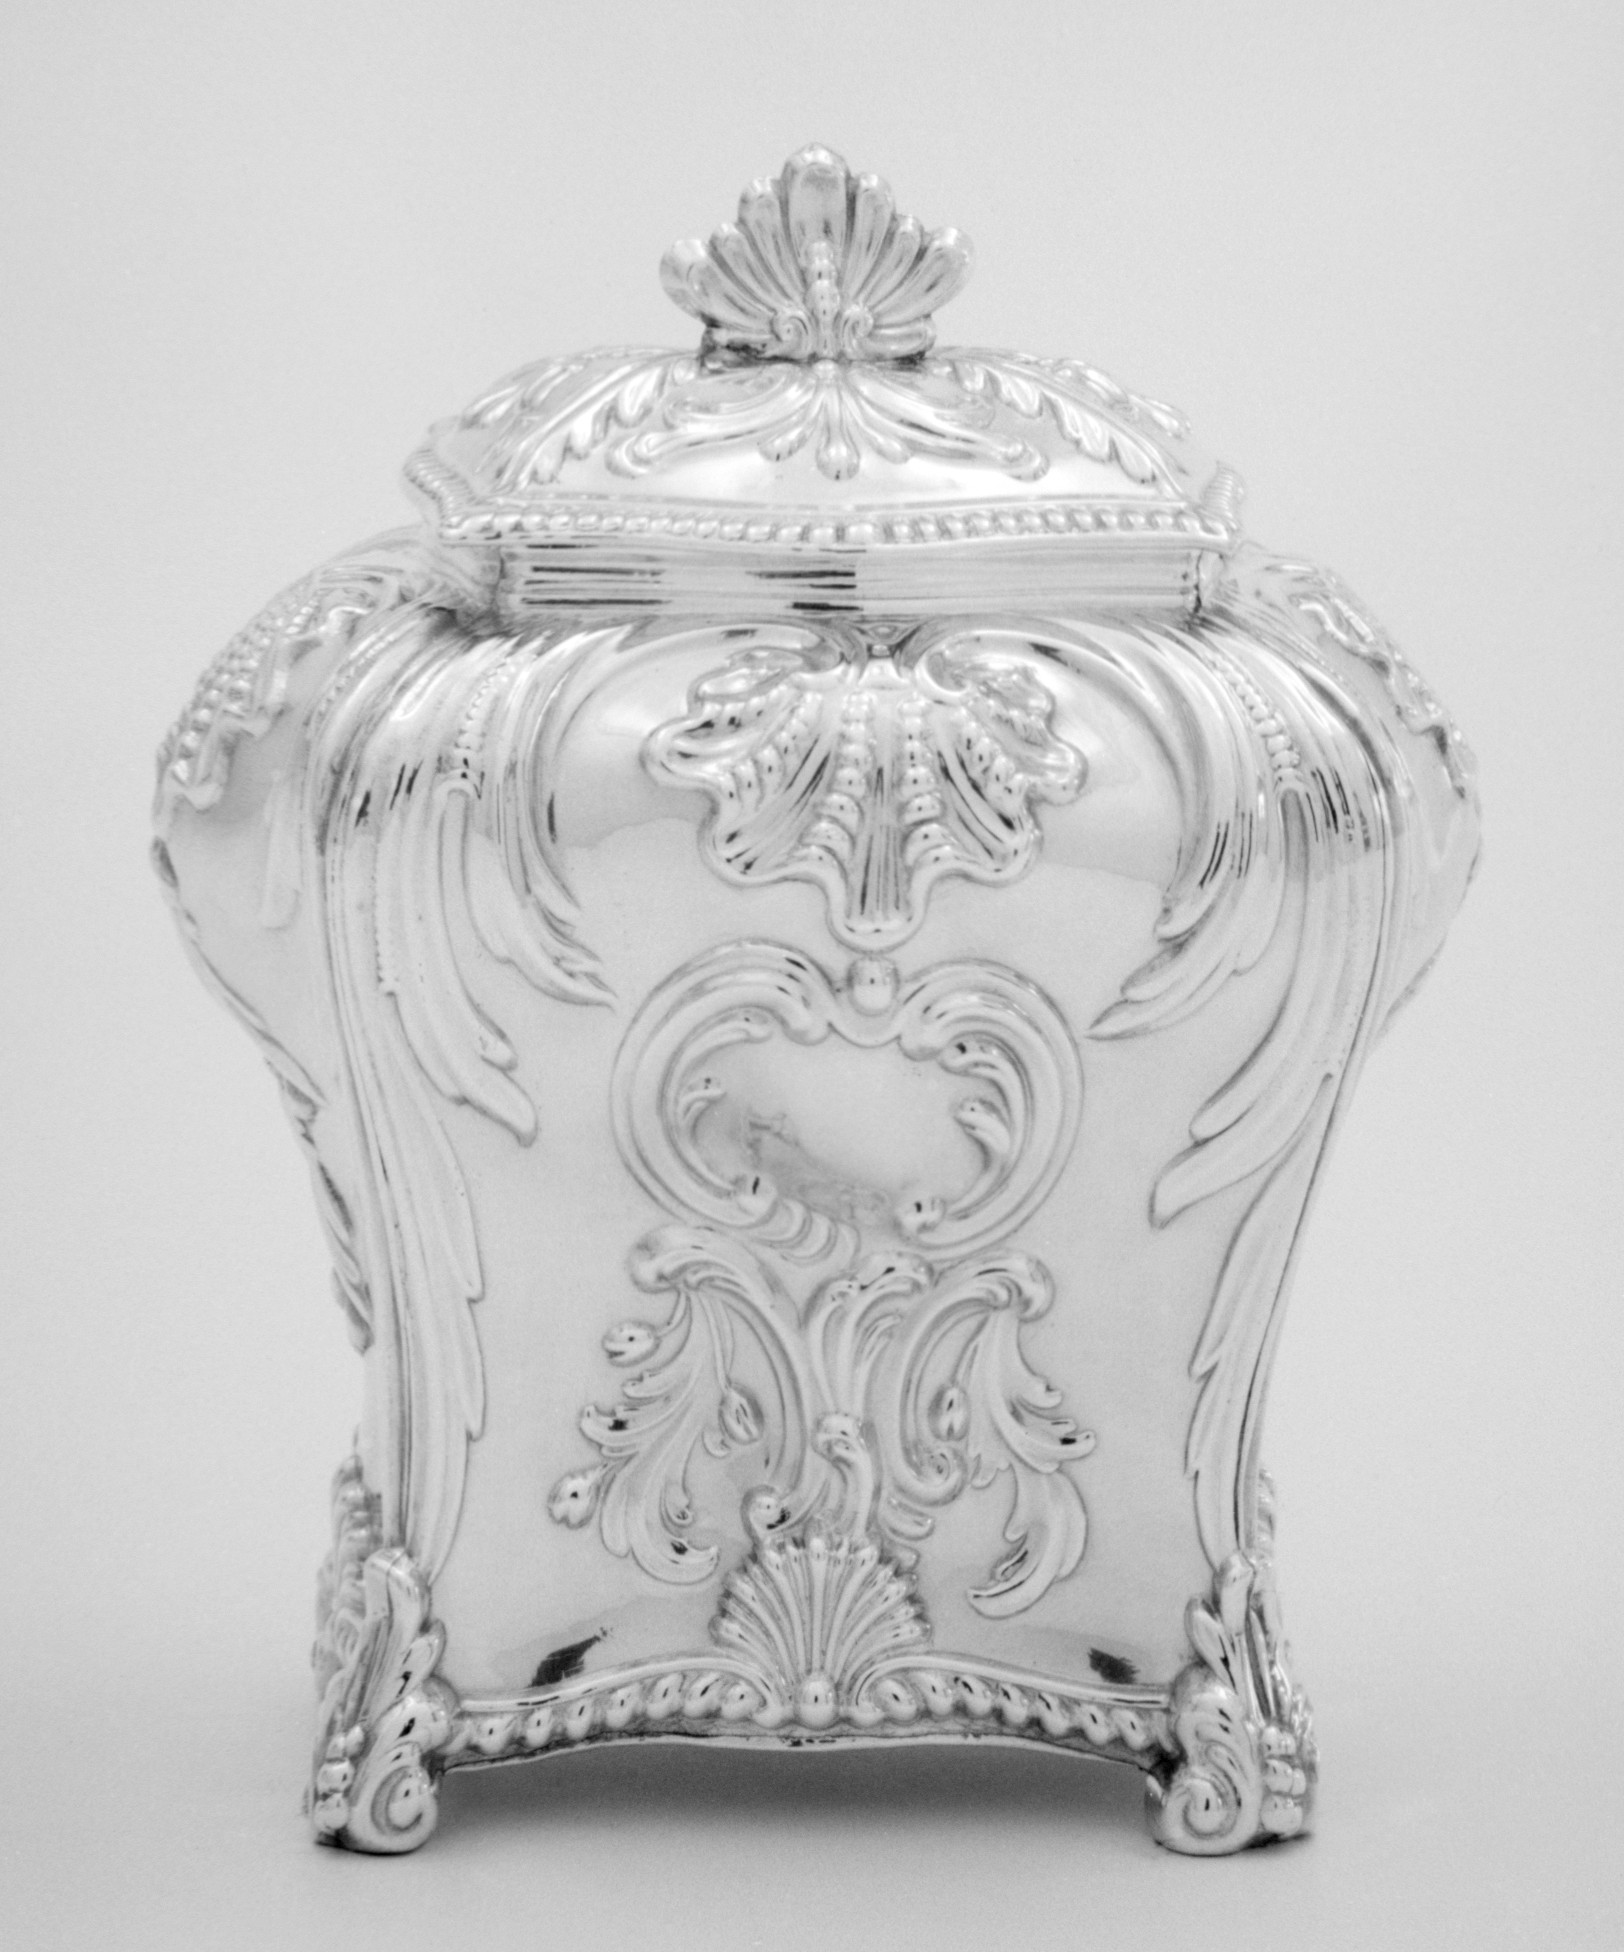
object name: tea caddy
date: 1766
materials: silver